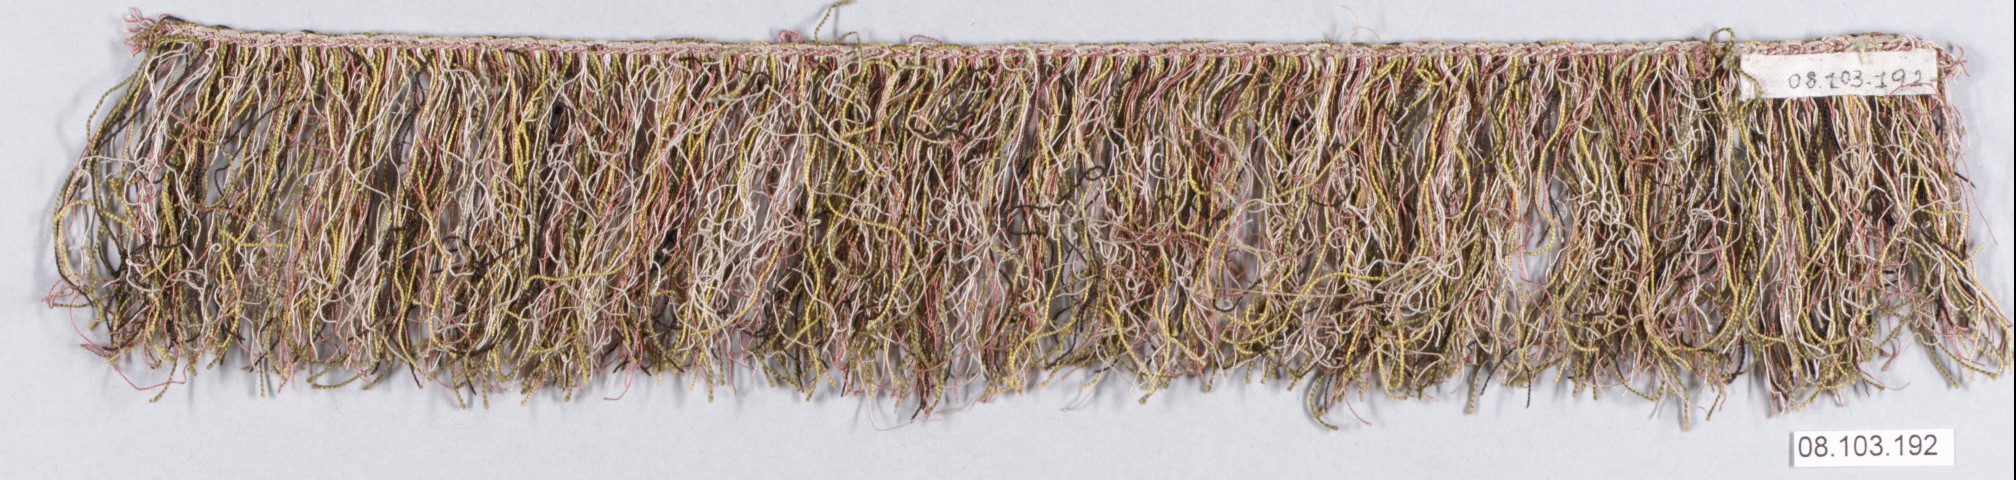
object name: fringe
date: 1801-1900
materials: silk